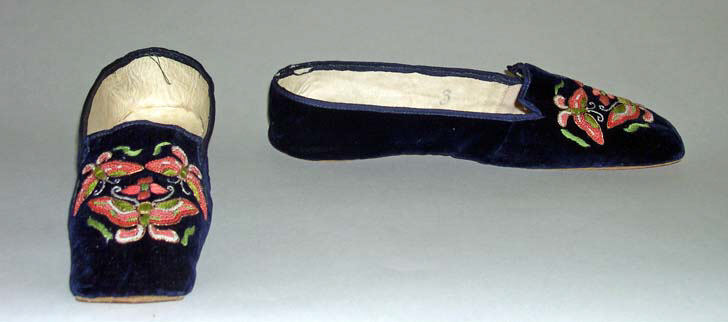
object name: slipper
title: Slippers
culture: american or european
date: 1830-1849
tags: butterflies